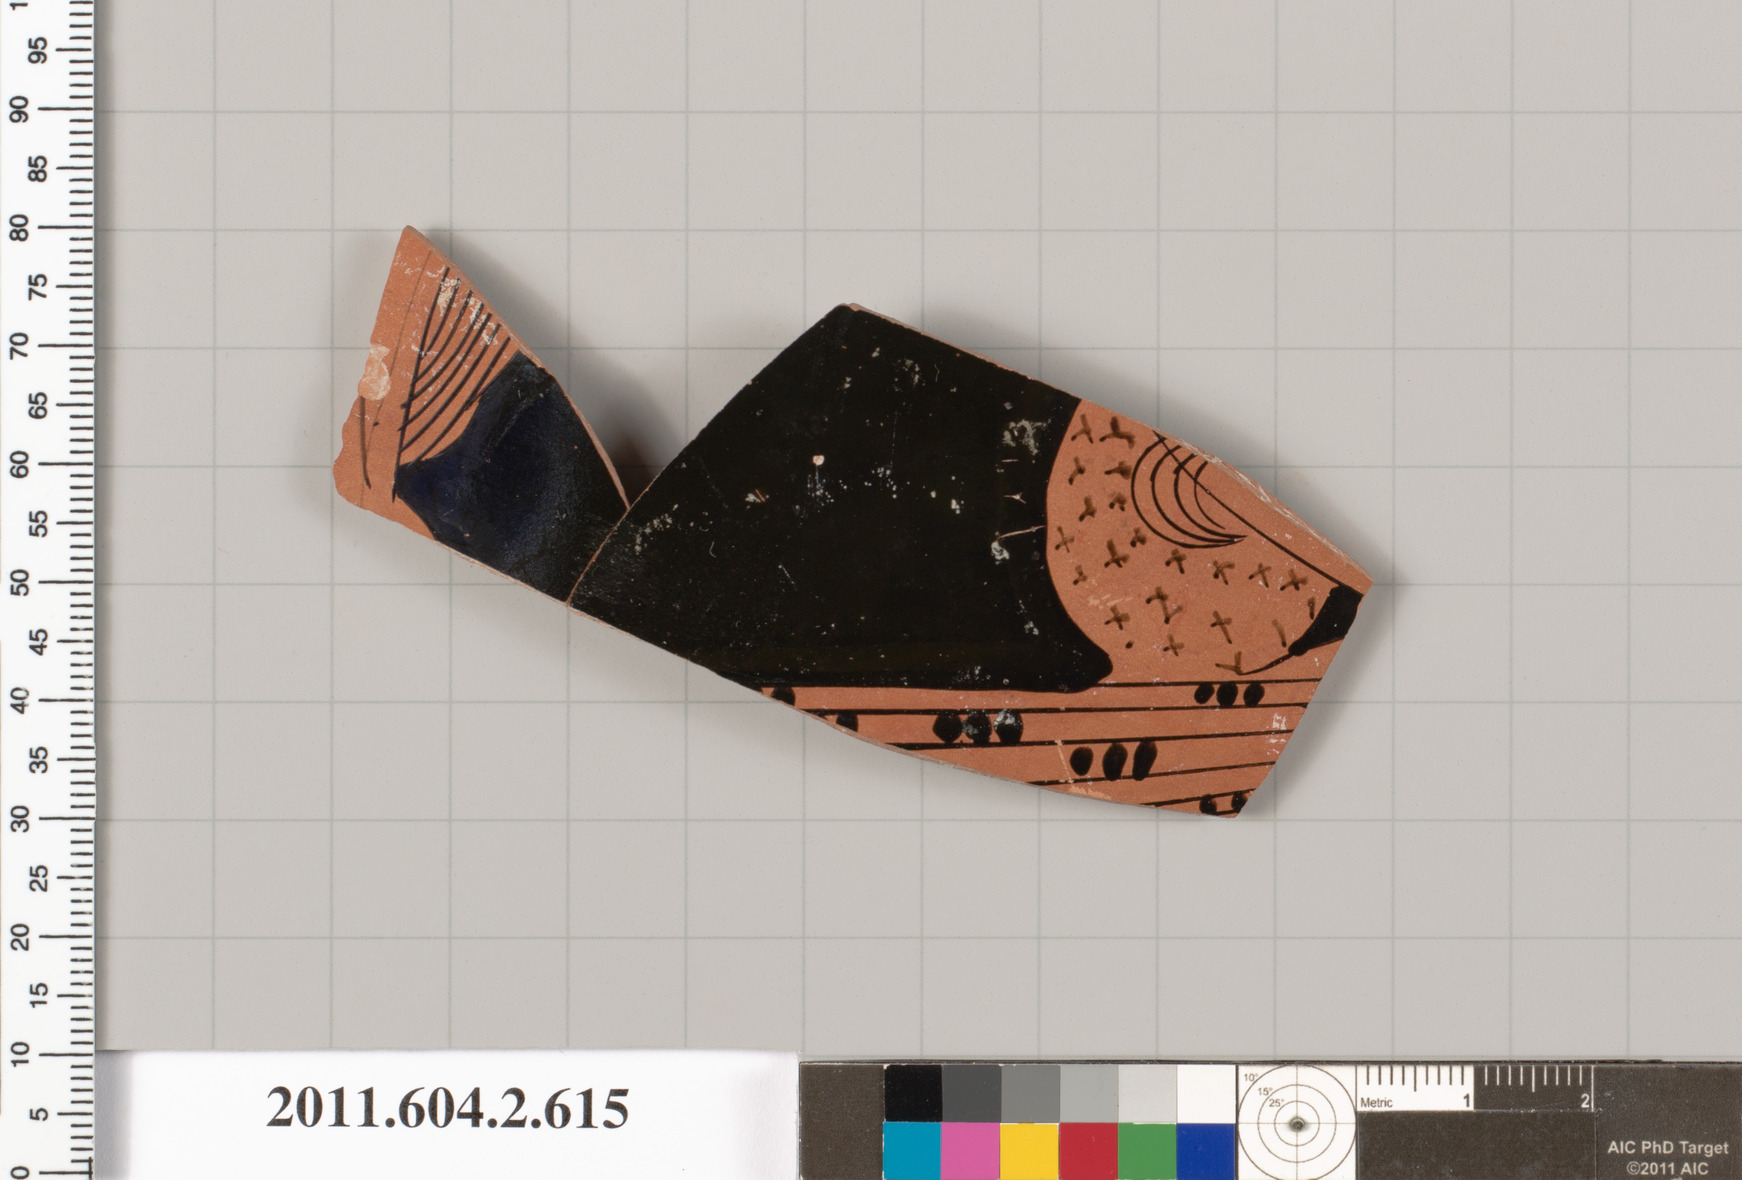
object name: column krater fragment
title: Terracotta fragment of a column-krater (bowl for mixing wine and water)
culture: greek, attic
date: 475-451 BCE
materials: terracotta